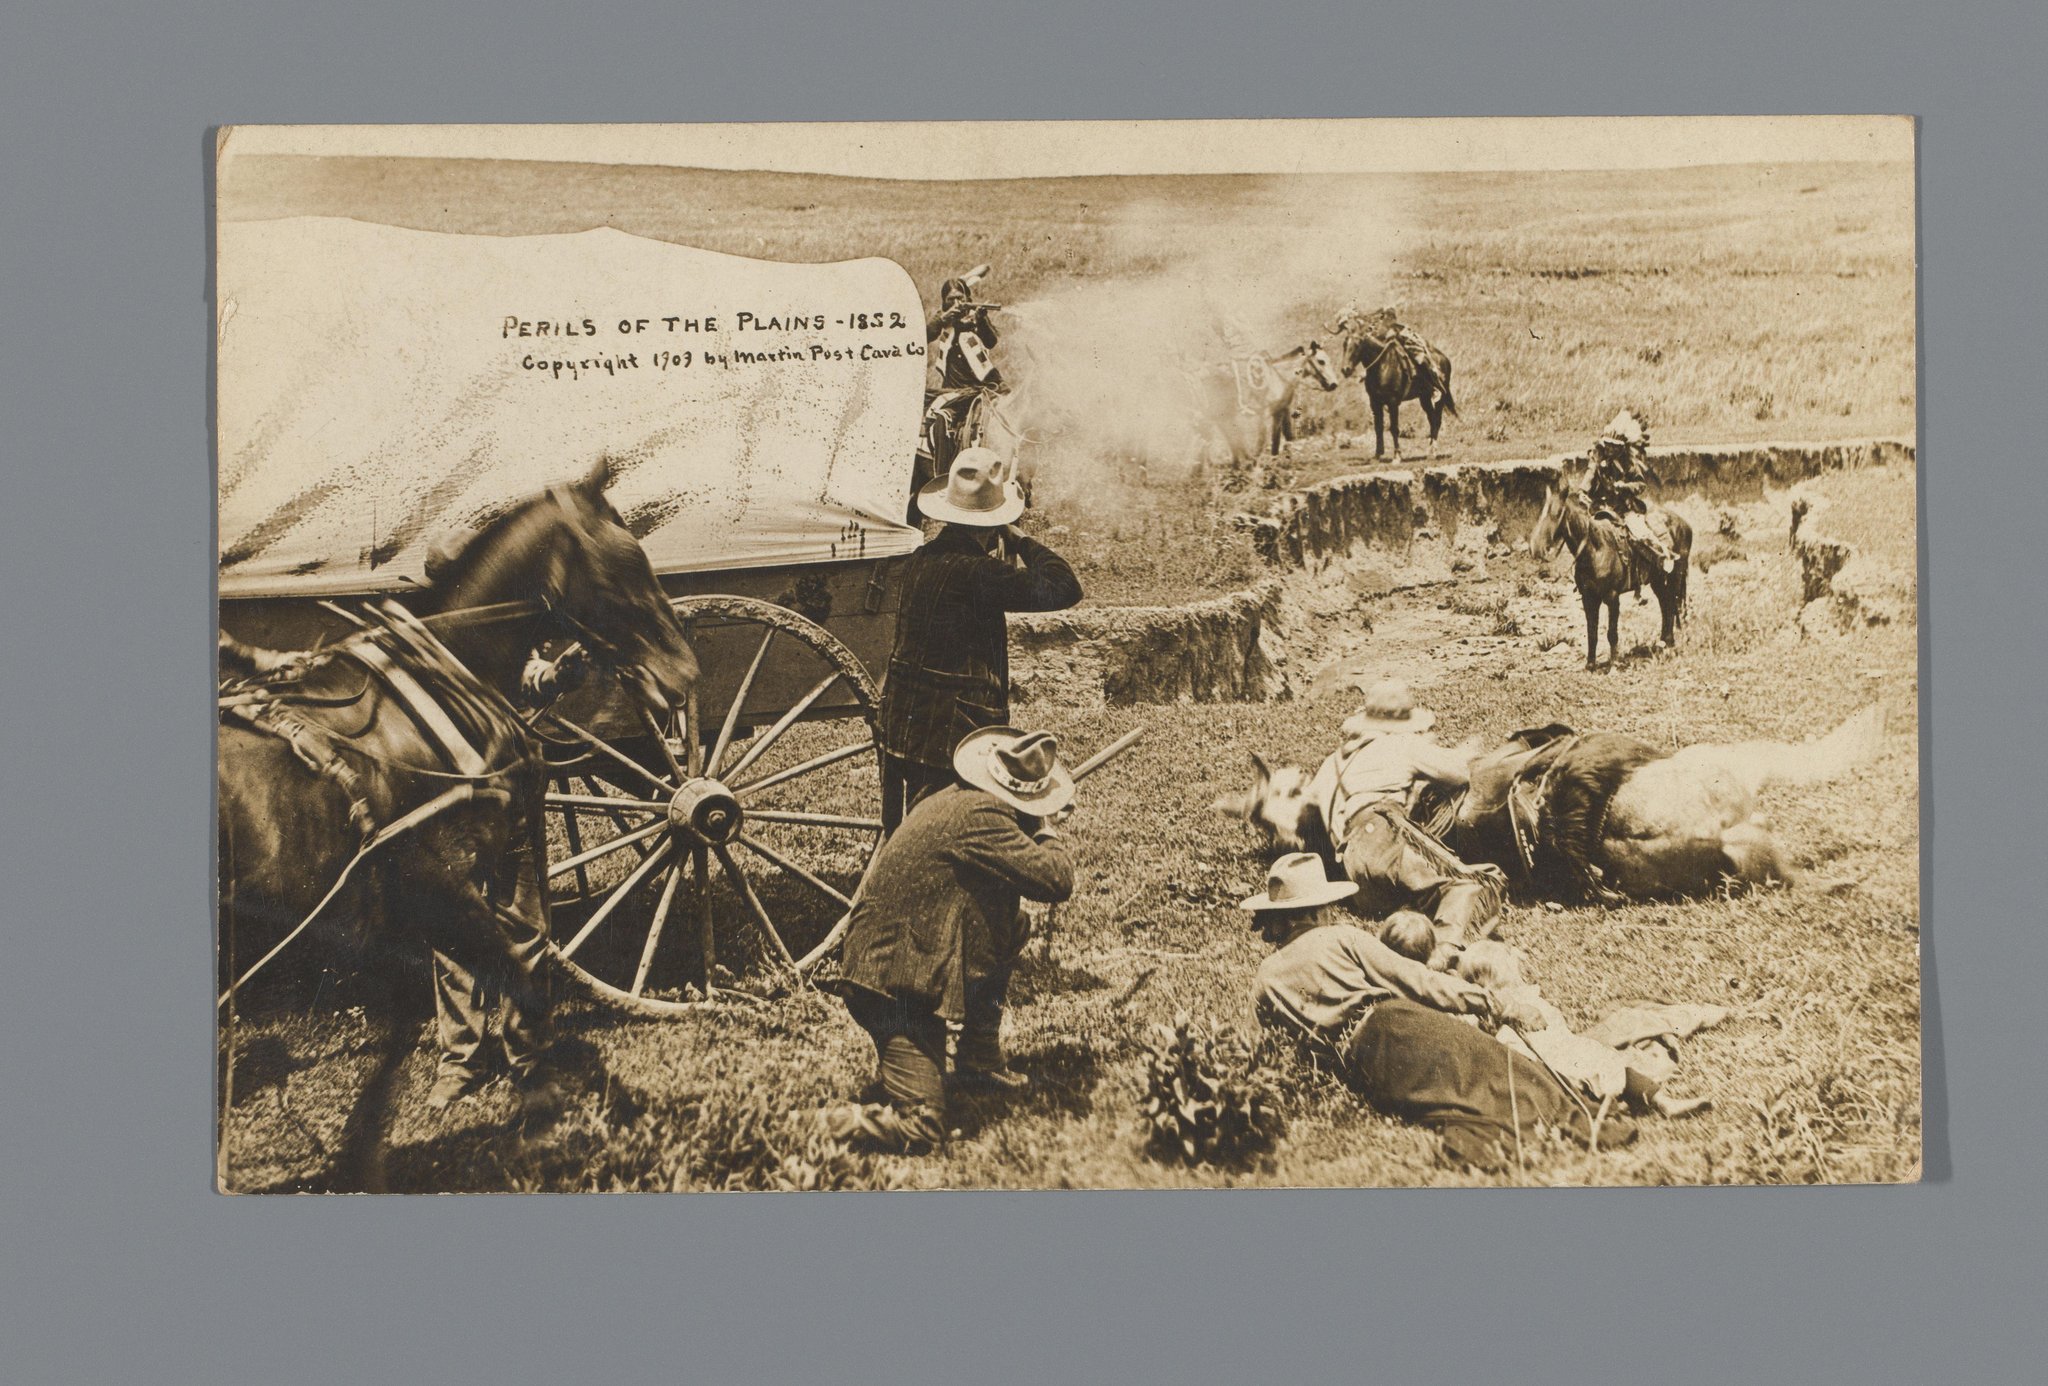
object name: ansichtkaart, prentbriefkaart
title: Fotomontage/trucage met gevecht tussen kolonisten en oorspronkelijke bewoners van Noord-Amerika in een landschap met huifkar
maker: Anonymous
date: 1907-1920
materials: photographic support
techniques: photography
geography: united states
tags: united states of america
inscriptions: inscription: ‘Perils of the Plains – 1852 / Copyright 1909 by Martin Post Card Co.’, inscription